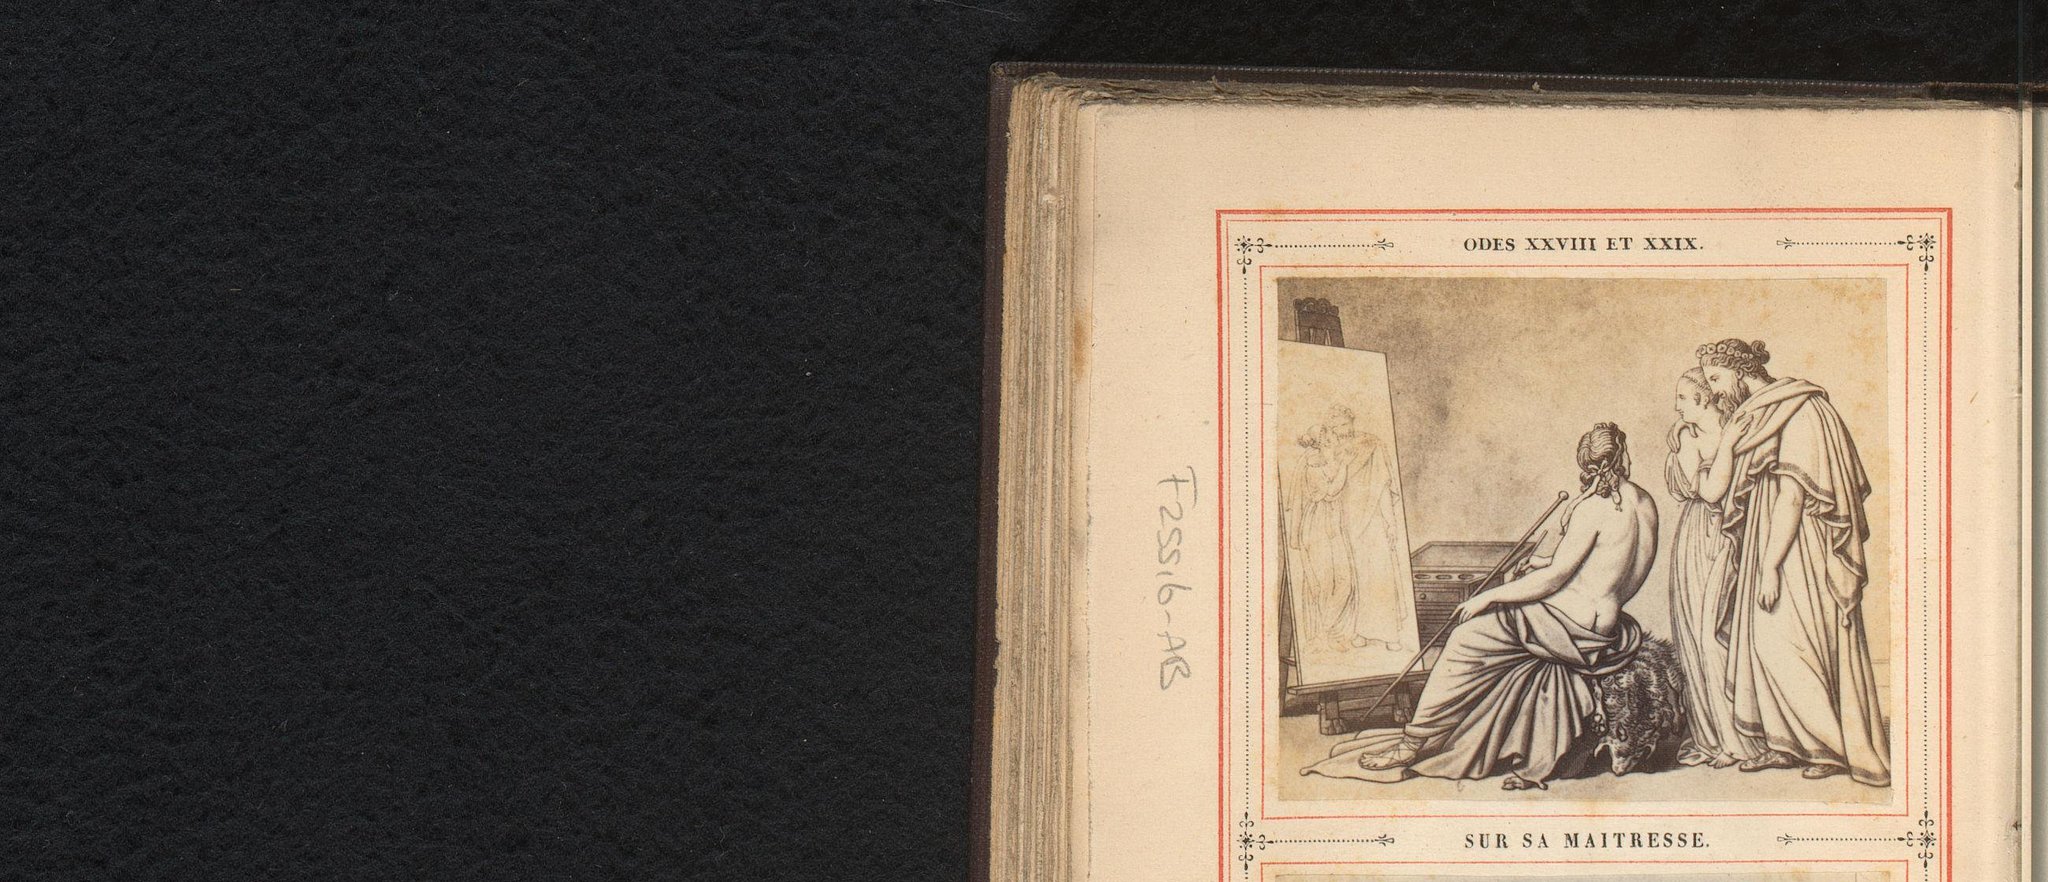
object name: page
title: Fotoreproductie van een tekening van Girodet, paar bij schilder en ezel, illustratie bij Apothéose d'Anacréon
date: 1859-1864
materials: paper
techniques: albumen print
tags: painter at work, in his studio, gods ~ classical mythology